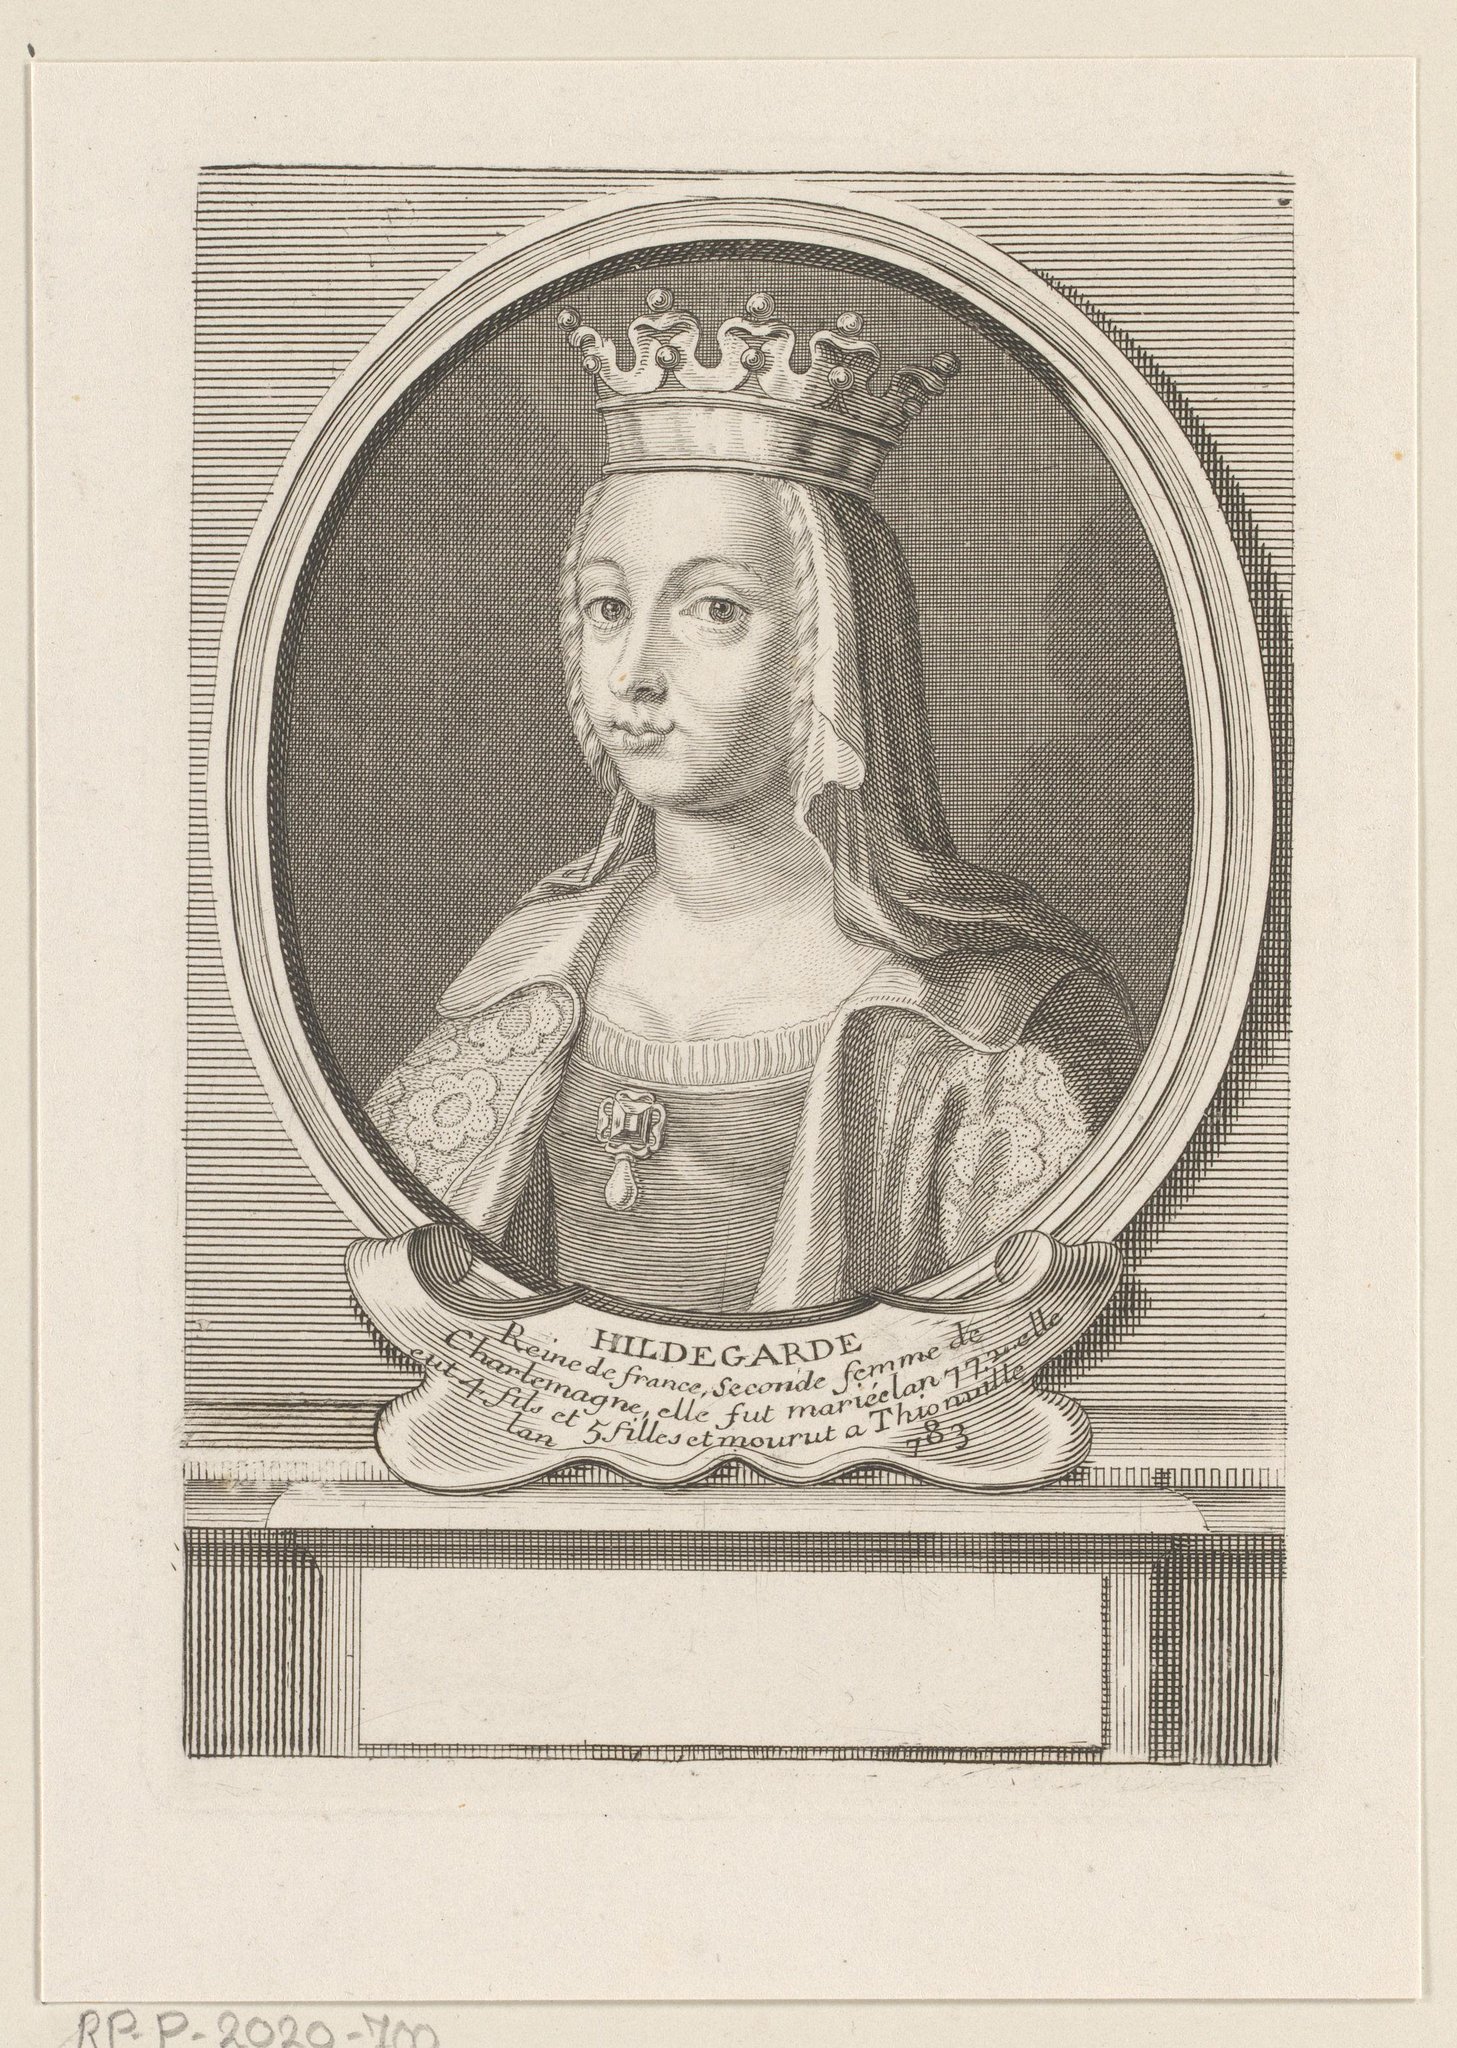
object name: print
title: Portret van Hildegard, koningin der Franken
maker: Anonymous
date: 1720-1800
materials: paper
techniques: engraving, etching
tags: historical persons - bb - woman, queen